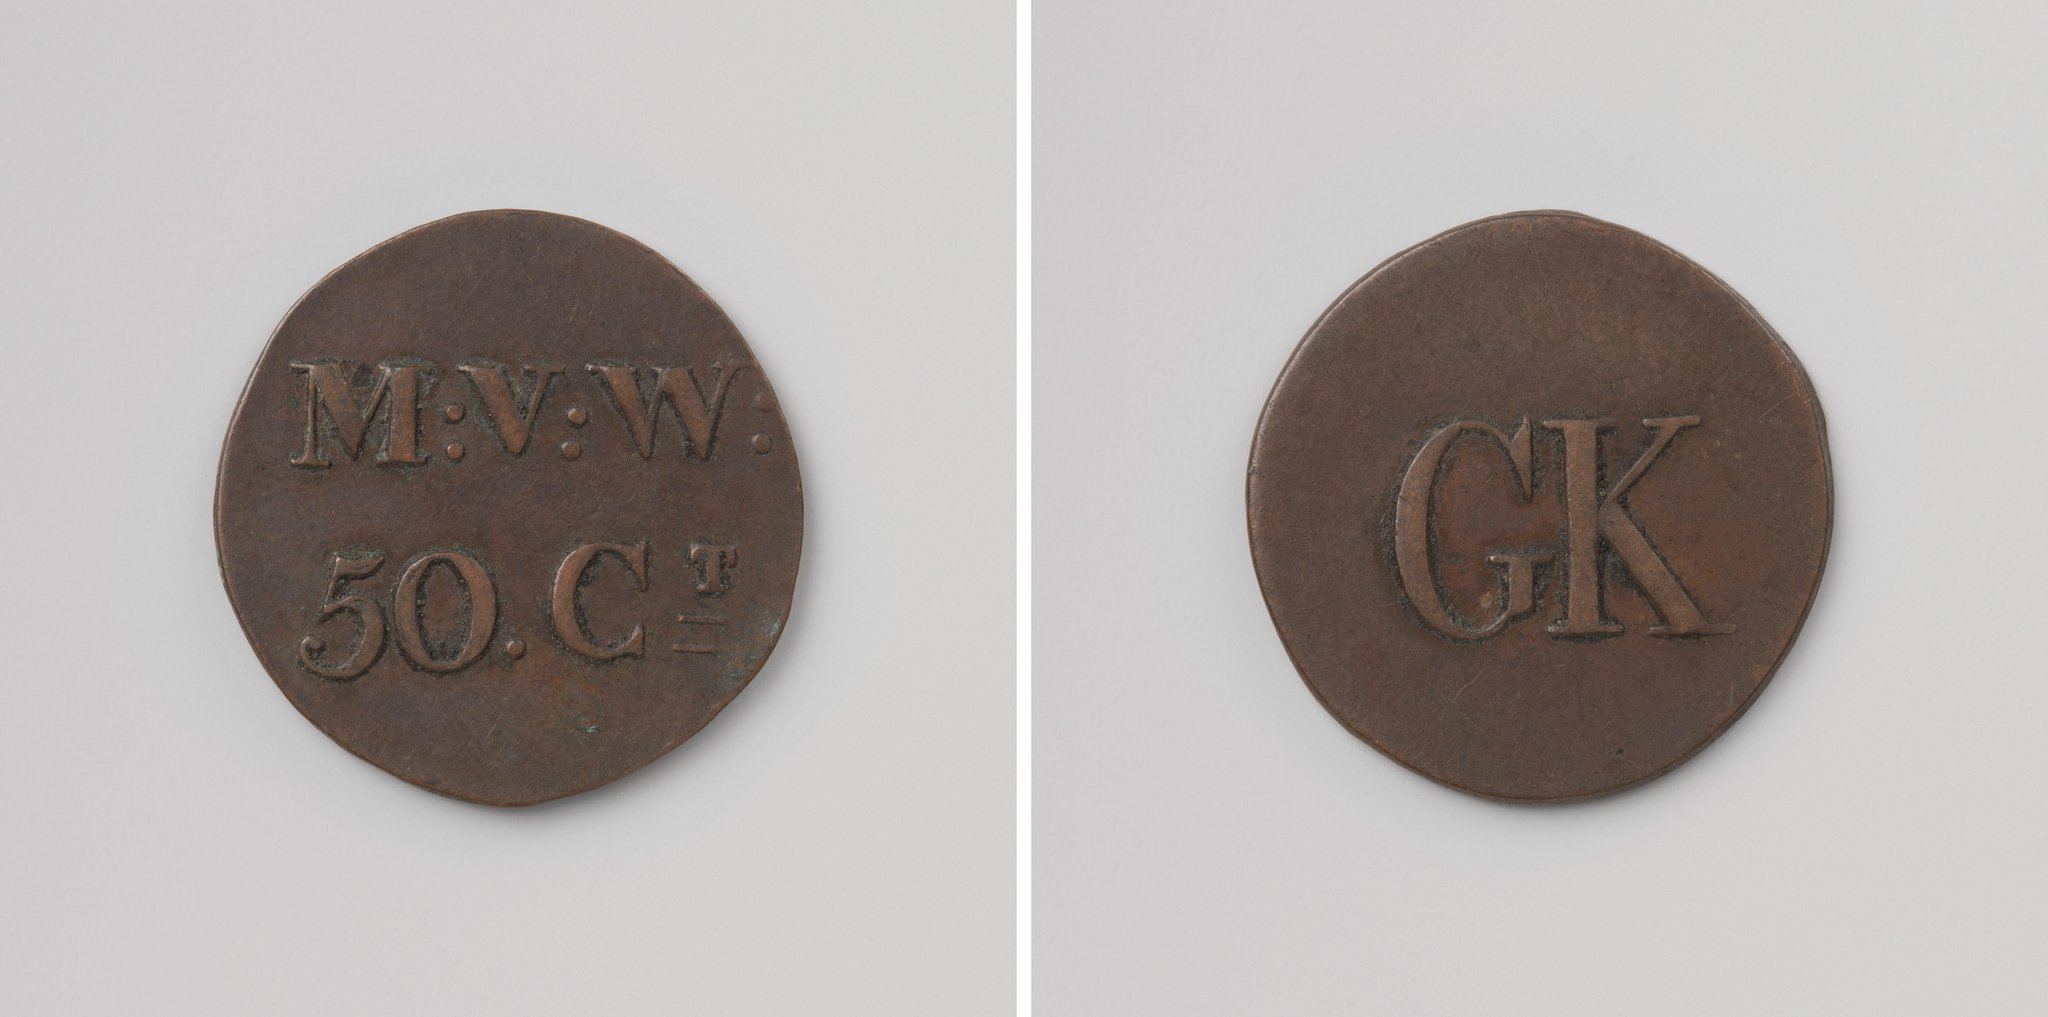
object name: vijftig cent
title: Huismunt geslagen op last van de Maatschappij van Weldadigheid ter waarde van 50 cent, ten behoeve van de Gewone Koloniën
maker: Anonymous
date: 1818-1859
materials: copper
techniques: striking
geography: netherlands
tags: maatschappij van weldadigheid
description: Voorzijde: opschrift boven waardeaanduiding. Keerzijde: opschrift G en K